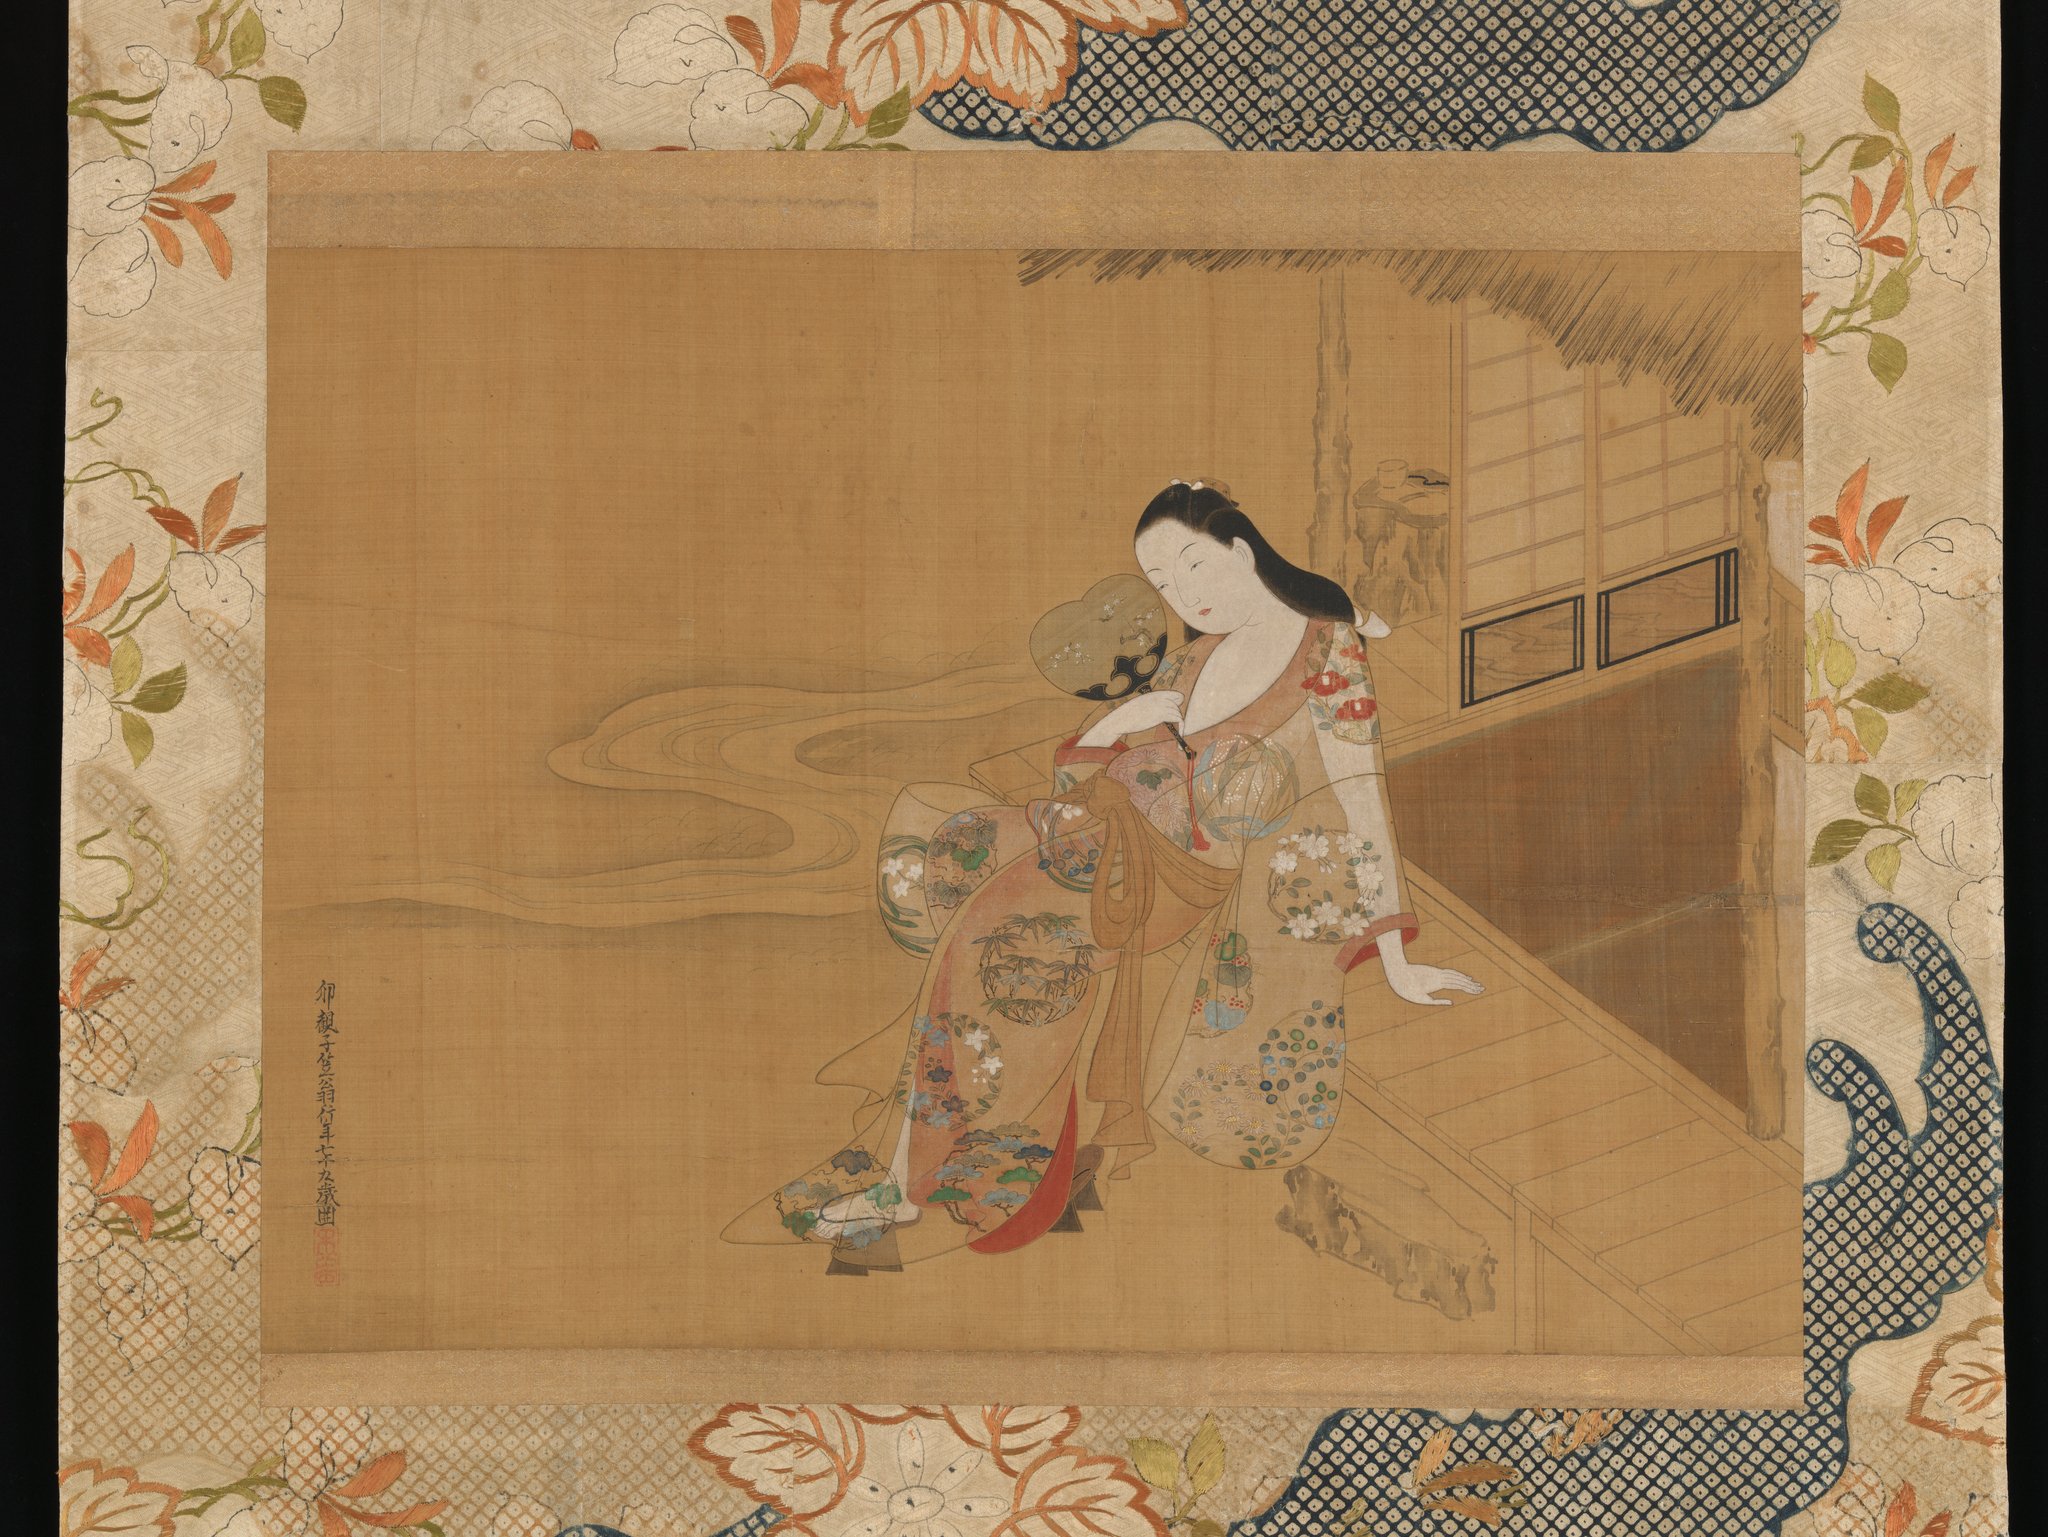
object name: hanging scroll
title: Courtesan Enjoying a Cool Summer Evening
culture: japanese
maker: ogawa haritsu (ritsuō)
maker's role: artist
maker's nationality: japanese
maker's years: 1663-1747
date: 1741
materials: ink, silk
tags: fans,women